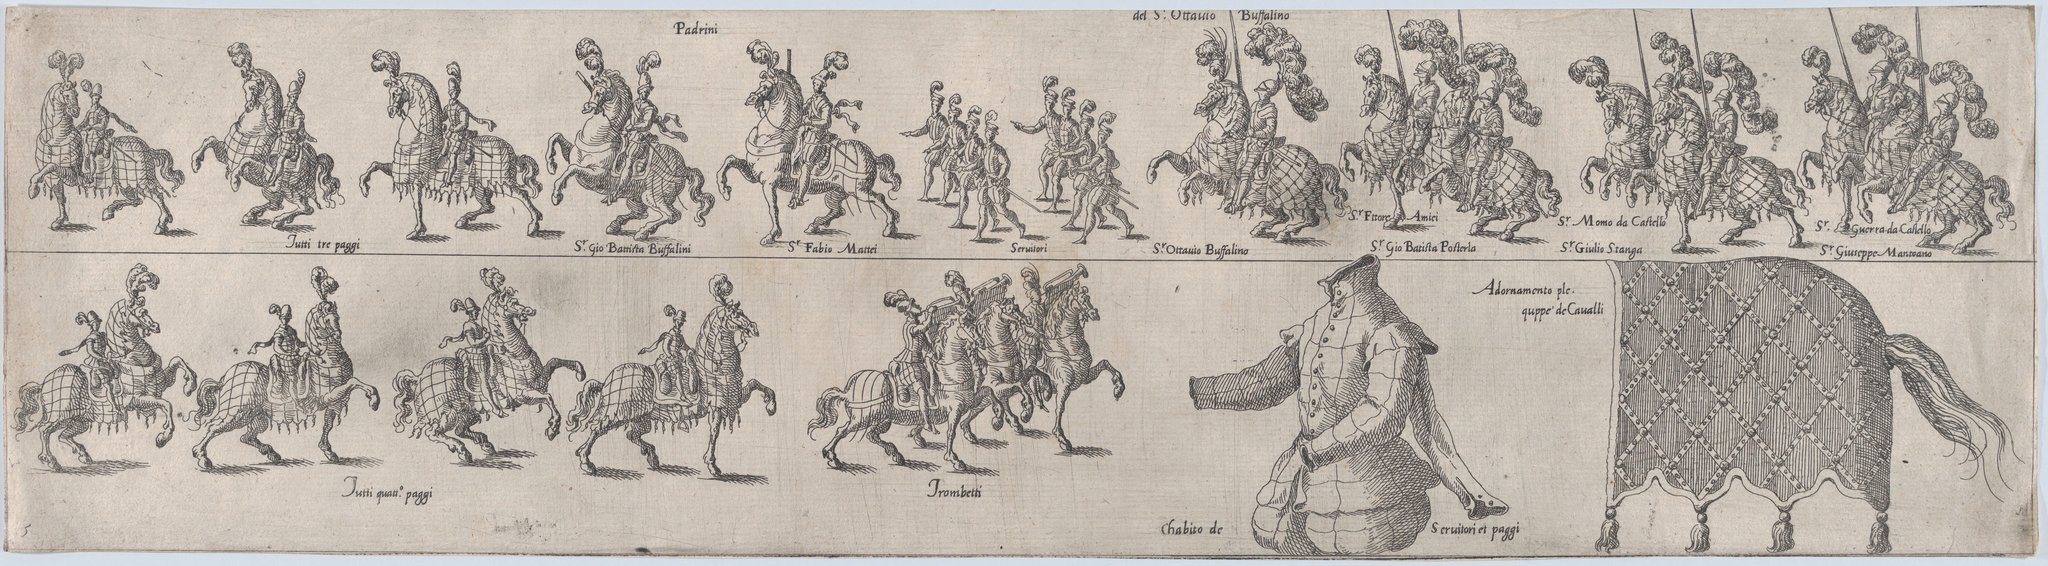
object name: print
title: Plate depicting Ottavio Buffalino, from a series of twelve showing knights and their attendants dressed for a tournament (plate 5)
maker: Anonymous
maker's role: artist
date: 1565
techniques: etching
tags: weapons,men,horses,knights